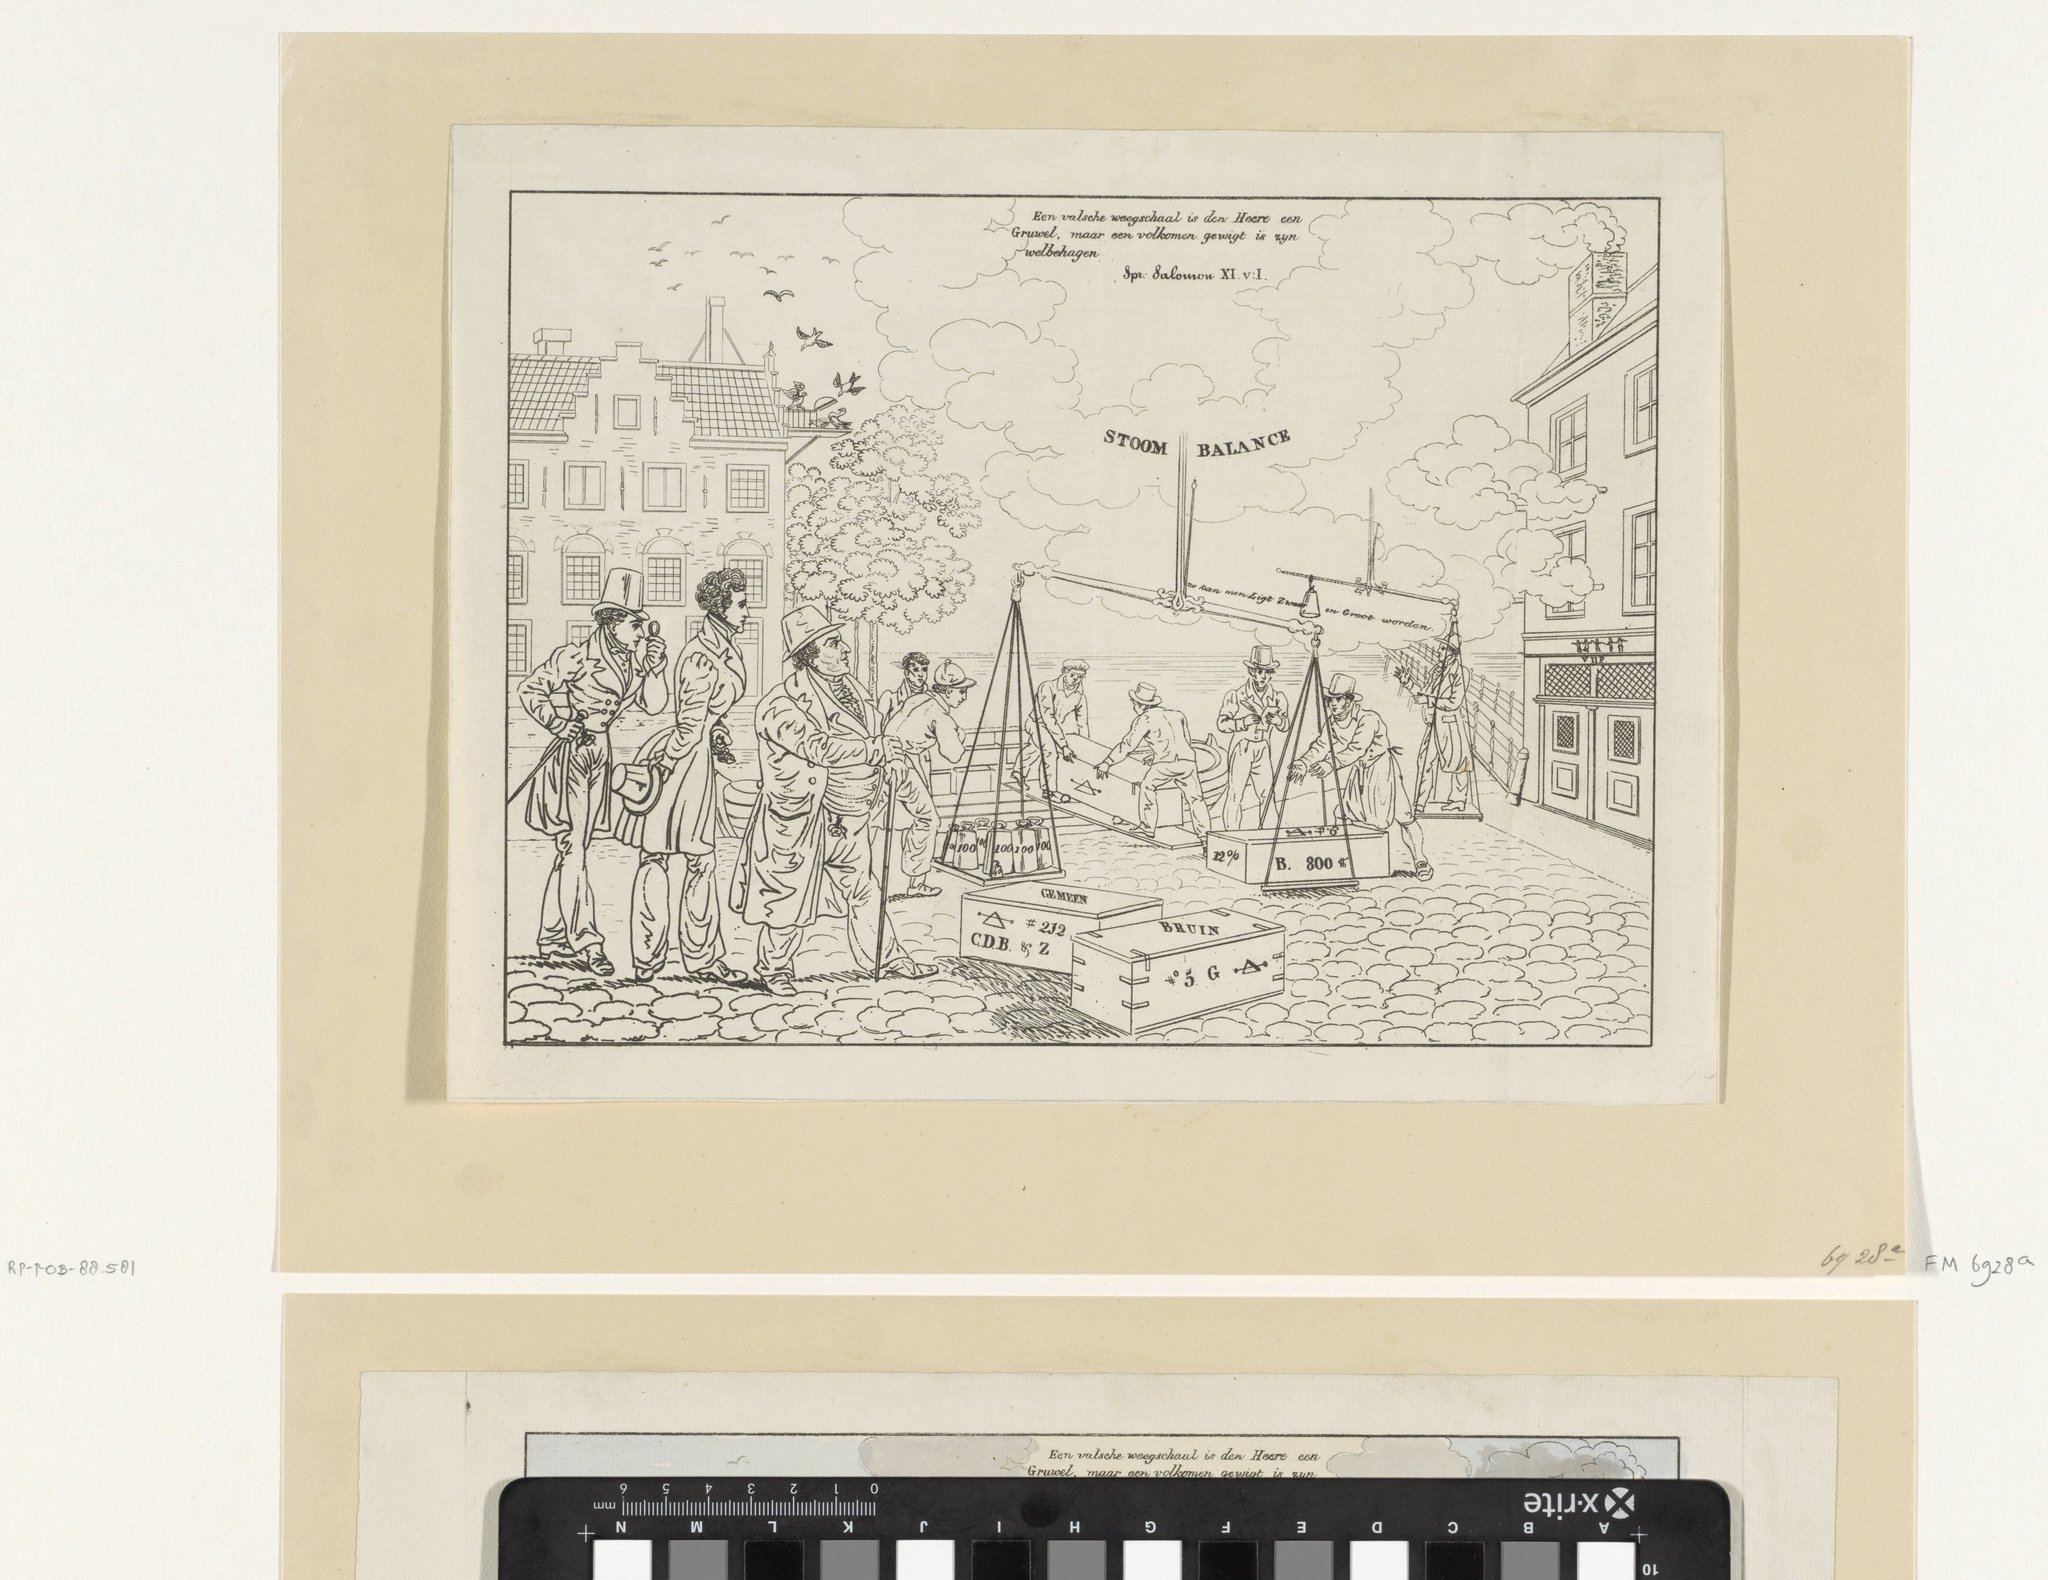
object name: print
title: Stoom Balance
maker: Anonymous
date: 1834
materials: paper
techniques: lithograph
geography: netherlands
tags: fraudulence, swindling, scales, industries ~ food, drink, stimulants, sugar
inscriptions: collector's mark: Lugt 2228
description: Spotprent op het bedrog met een valse weegschaal van de firma C. de Bruyn & Zonen, 1834. De firma bezat de eerste stoomsuikerraffinaderij aan de Lijnbaansgracht in Amsterdam. Op 8 januari 1834 werden zij betrapt op het gebruik van een balans waarvan een arm was verlengd. Centraal de valse balans hangend aan de stoomwolken die uit de fabriek 'De Vijf Gebroeders' komen en waarop kisten met suiker worden gewogen. Links C. de Bruyn met zijn twee zoons. In de wolken een bijbelcitaat.